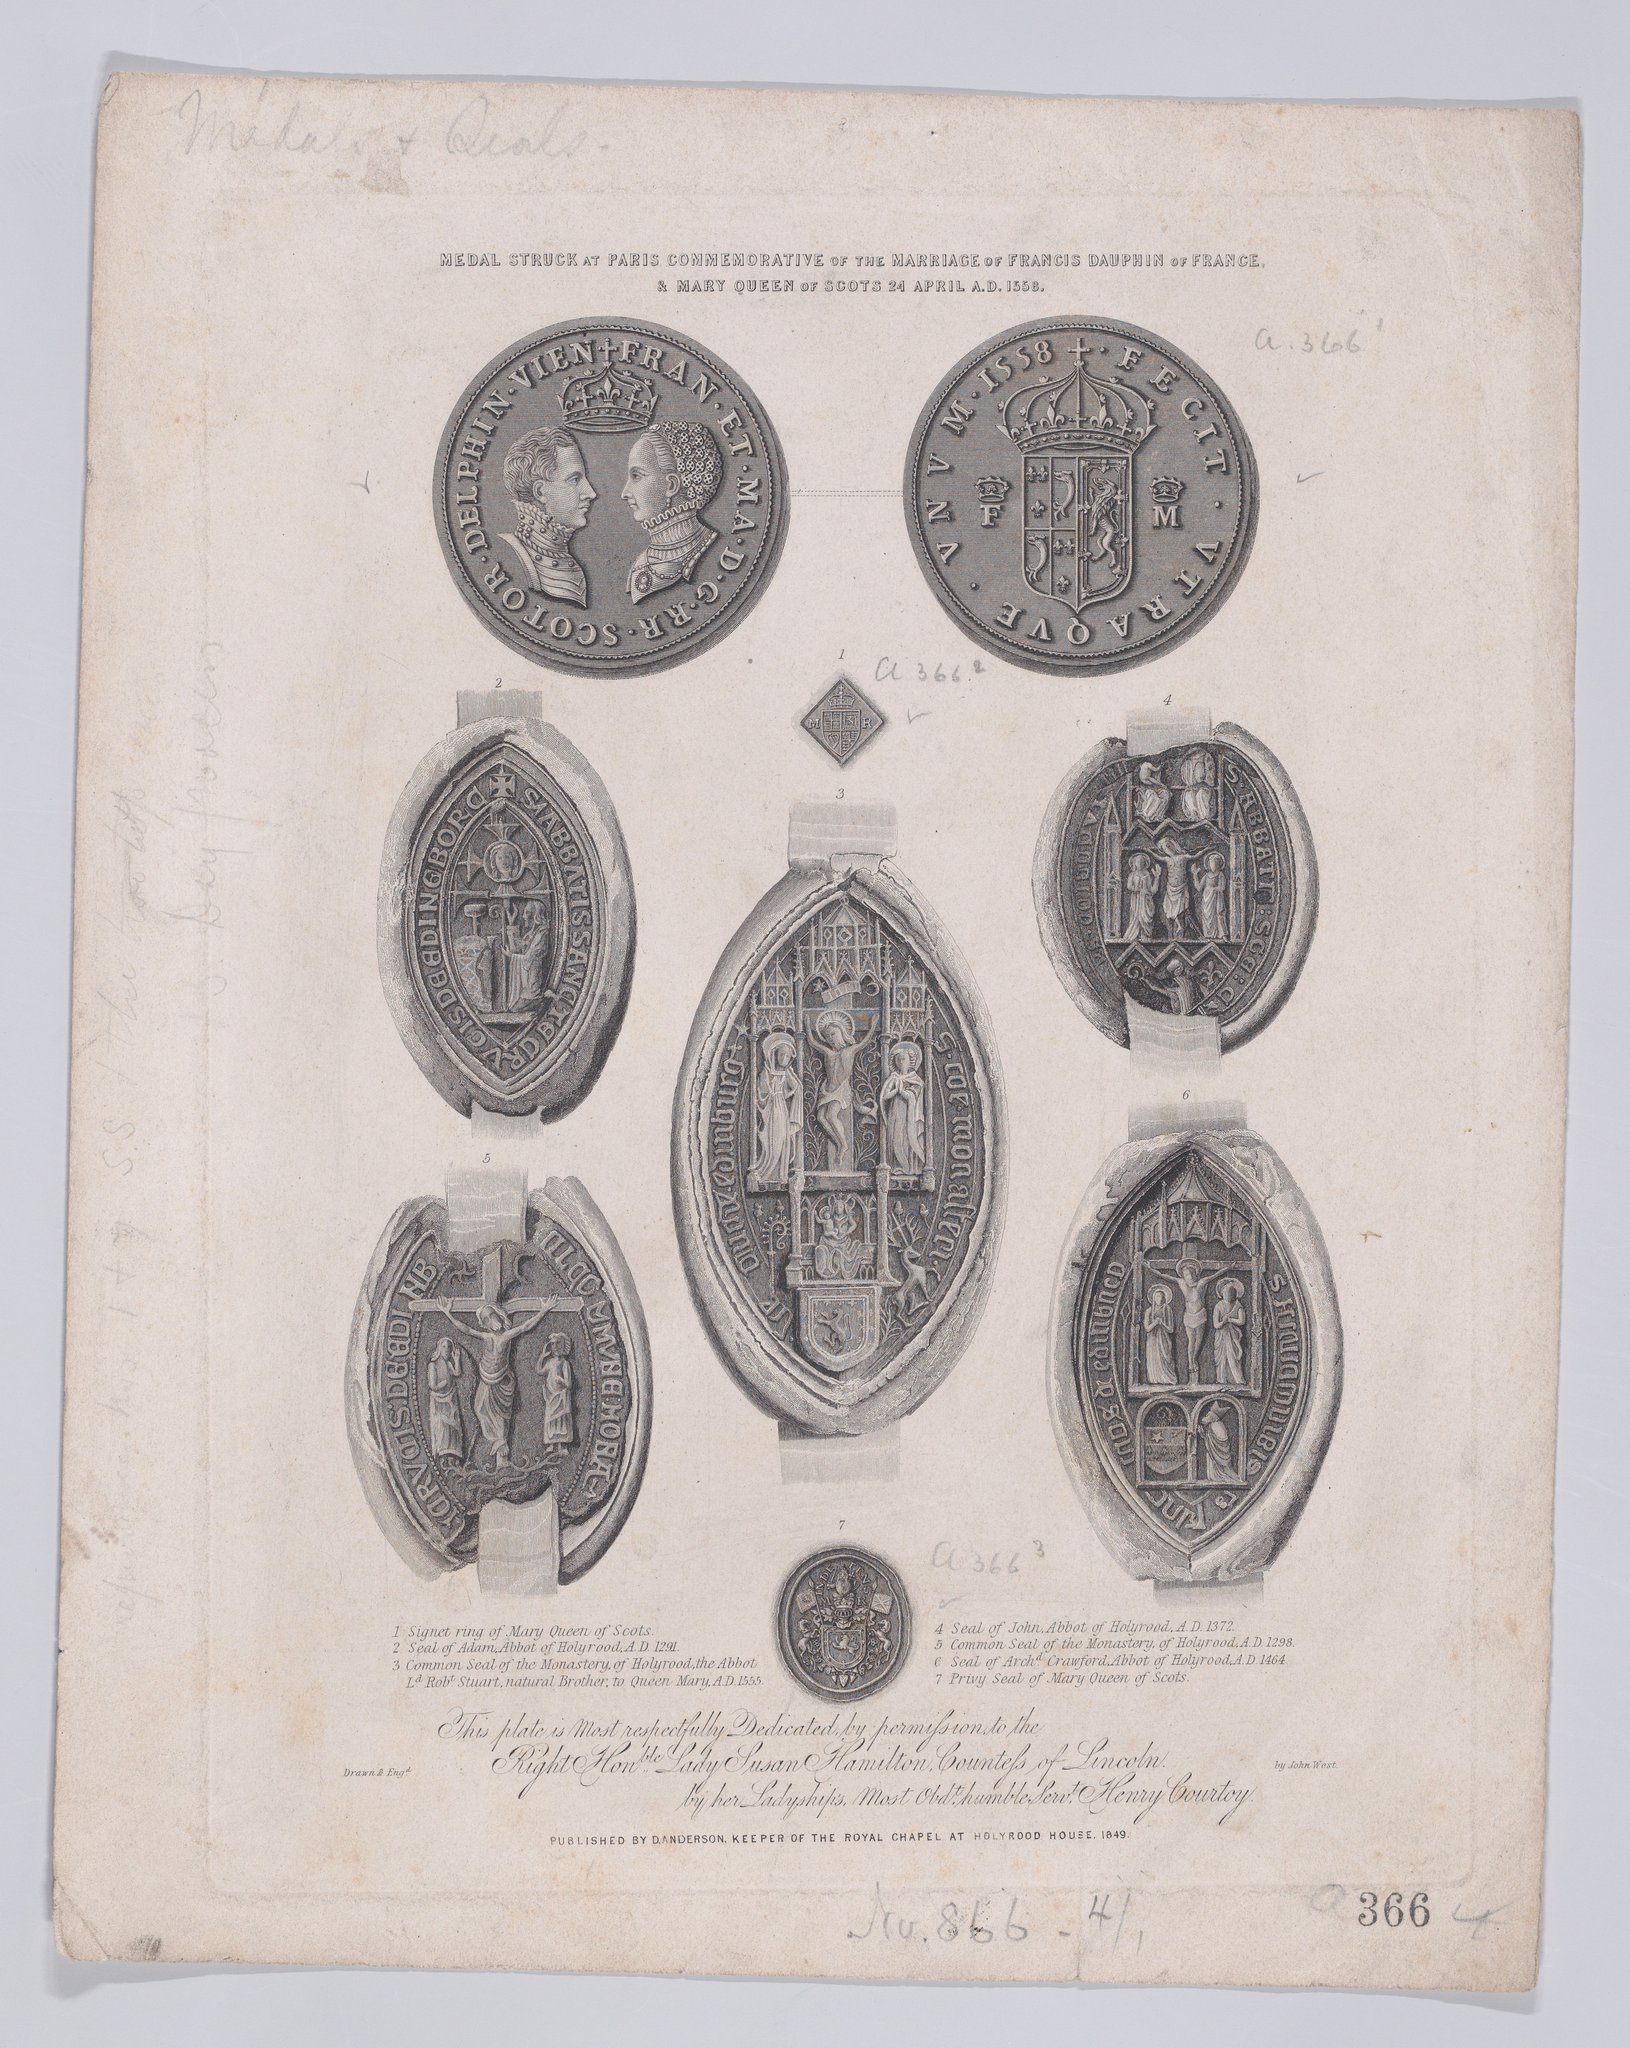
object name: print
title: Medal commemorating the marriage of Mary, Queen of Scots to the Dauphin Francis of France, with seals and signet rings relating to Queen Mary below (from "A Souvenir of the Abbey and Palace of Holyrood")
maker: john west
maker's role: artist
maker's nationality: british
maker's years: 1847-1855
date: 1849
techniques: engraving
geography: scotland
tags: crucifixion,coat of arms,mary queen of scots